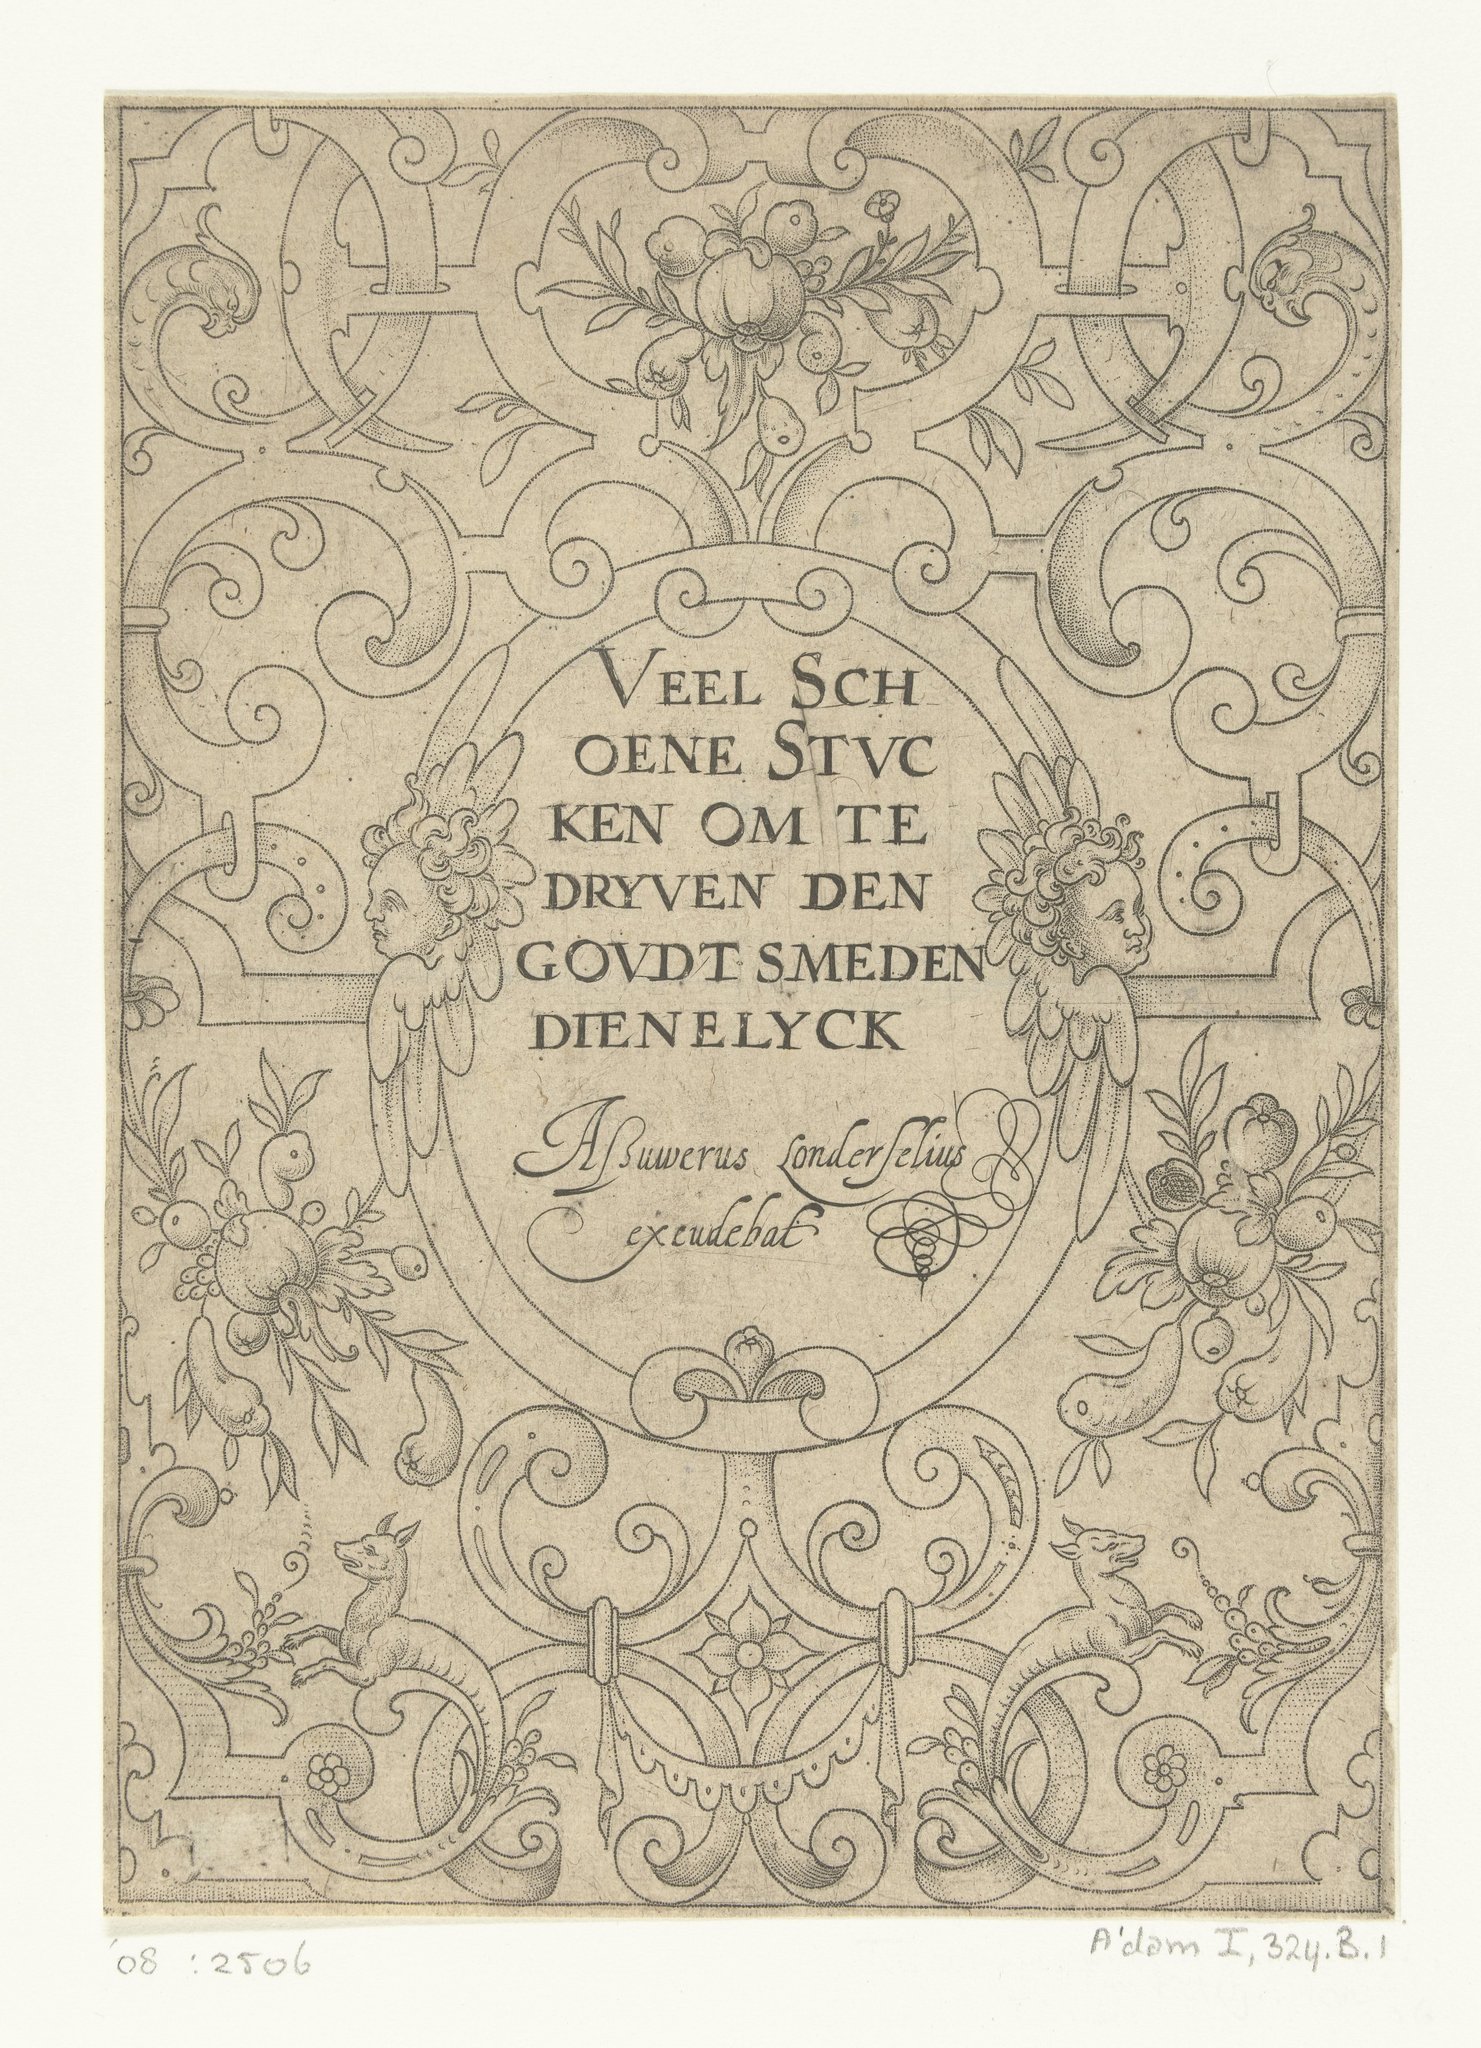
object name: print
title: Veel schoene stvcken om te dryven den govdt smeden dienelyck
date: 1594-1635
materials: paper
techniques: engraving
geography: germany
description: Titelblad. Ovaal met de titel, omgeven door krulwerk. Op het ovaal zit zowel links als rechts een cherubijntje. Tegenzijdige kopieën van de onder Orn Cat I-324.A vermelde serie. Titelblad en 14 deels genummerde bladen uit een serie van 25.